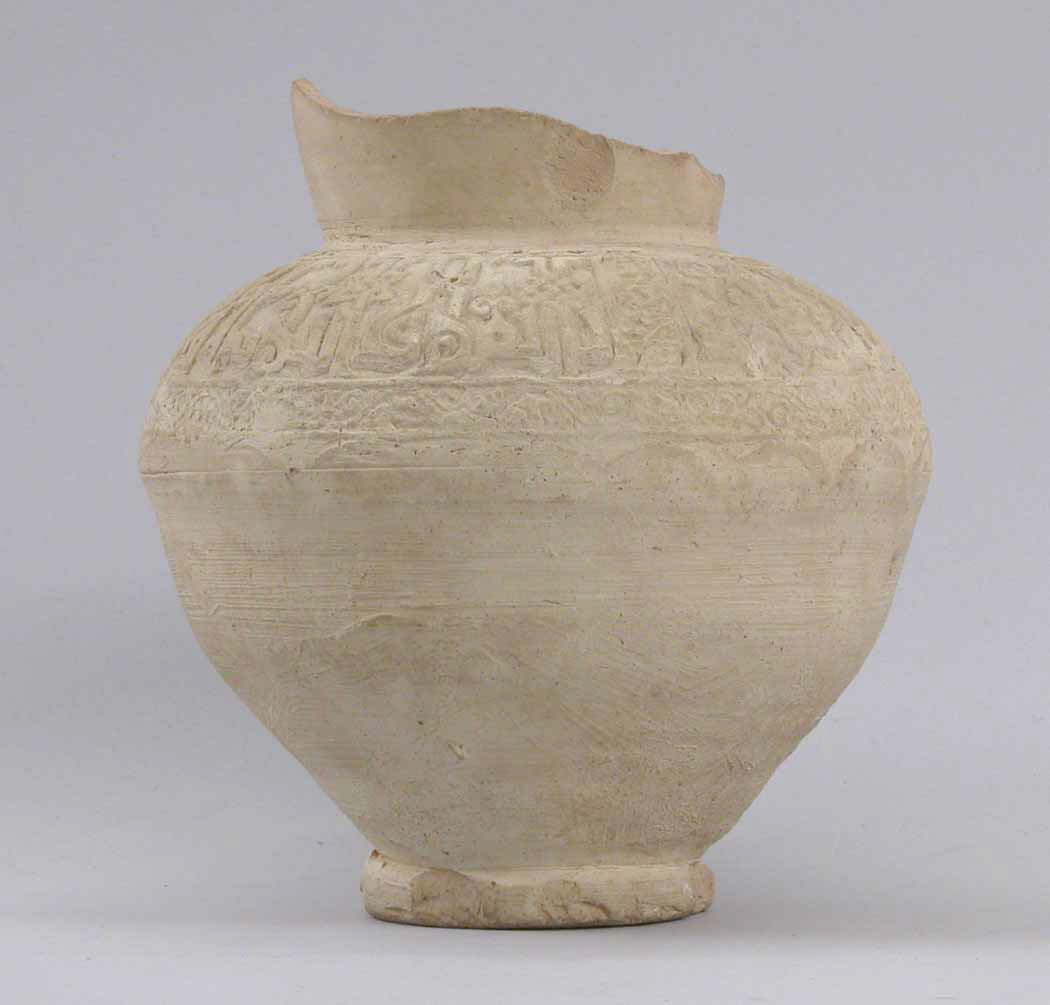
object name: jar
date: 1001-1200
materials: earthenware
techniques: molding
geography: iran